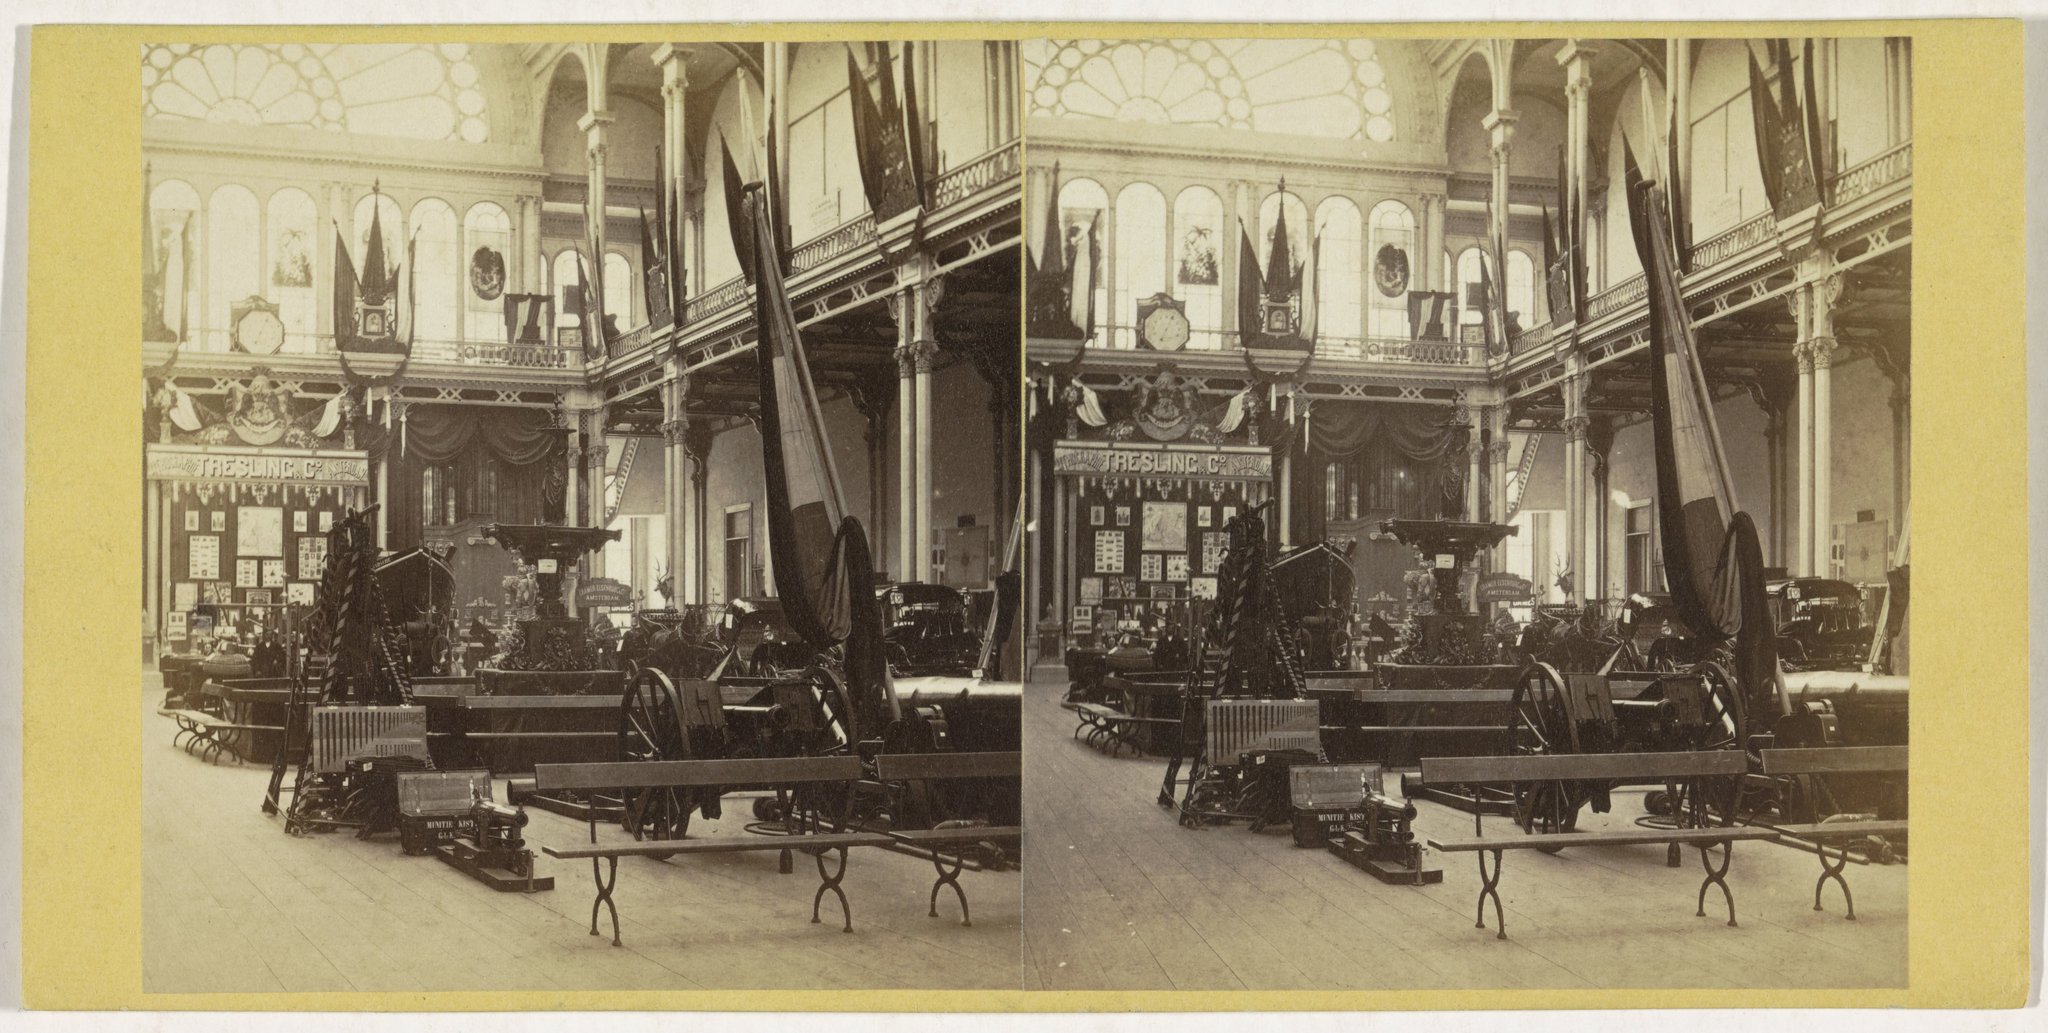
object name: stereograph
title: Tentoonstelling voor Nationale Nijverheid in het Paleis voor Volksvlijt, Amsterdam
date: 1866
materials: cardboard, paper, photographic support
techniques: albumen print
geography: amsterdam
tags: amsterdam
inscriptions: stamp: ‘JDB’, label: ‘Boek & Kunsthandel Jan D. Brouwer, Kalverstraat E, Nº 37 Amsterdam.’